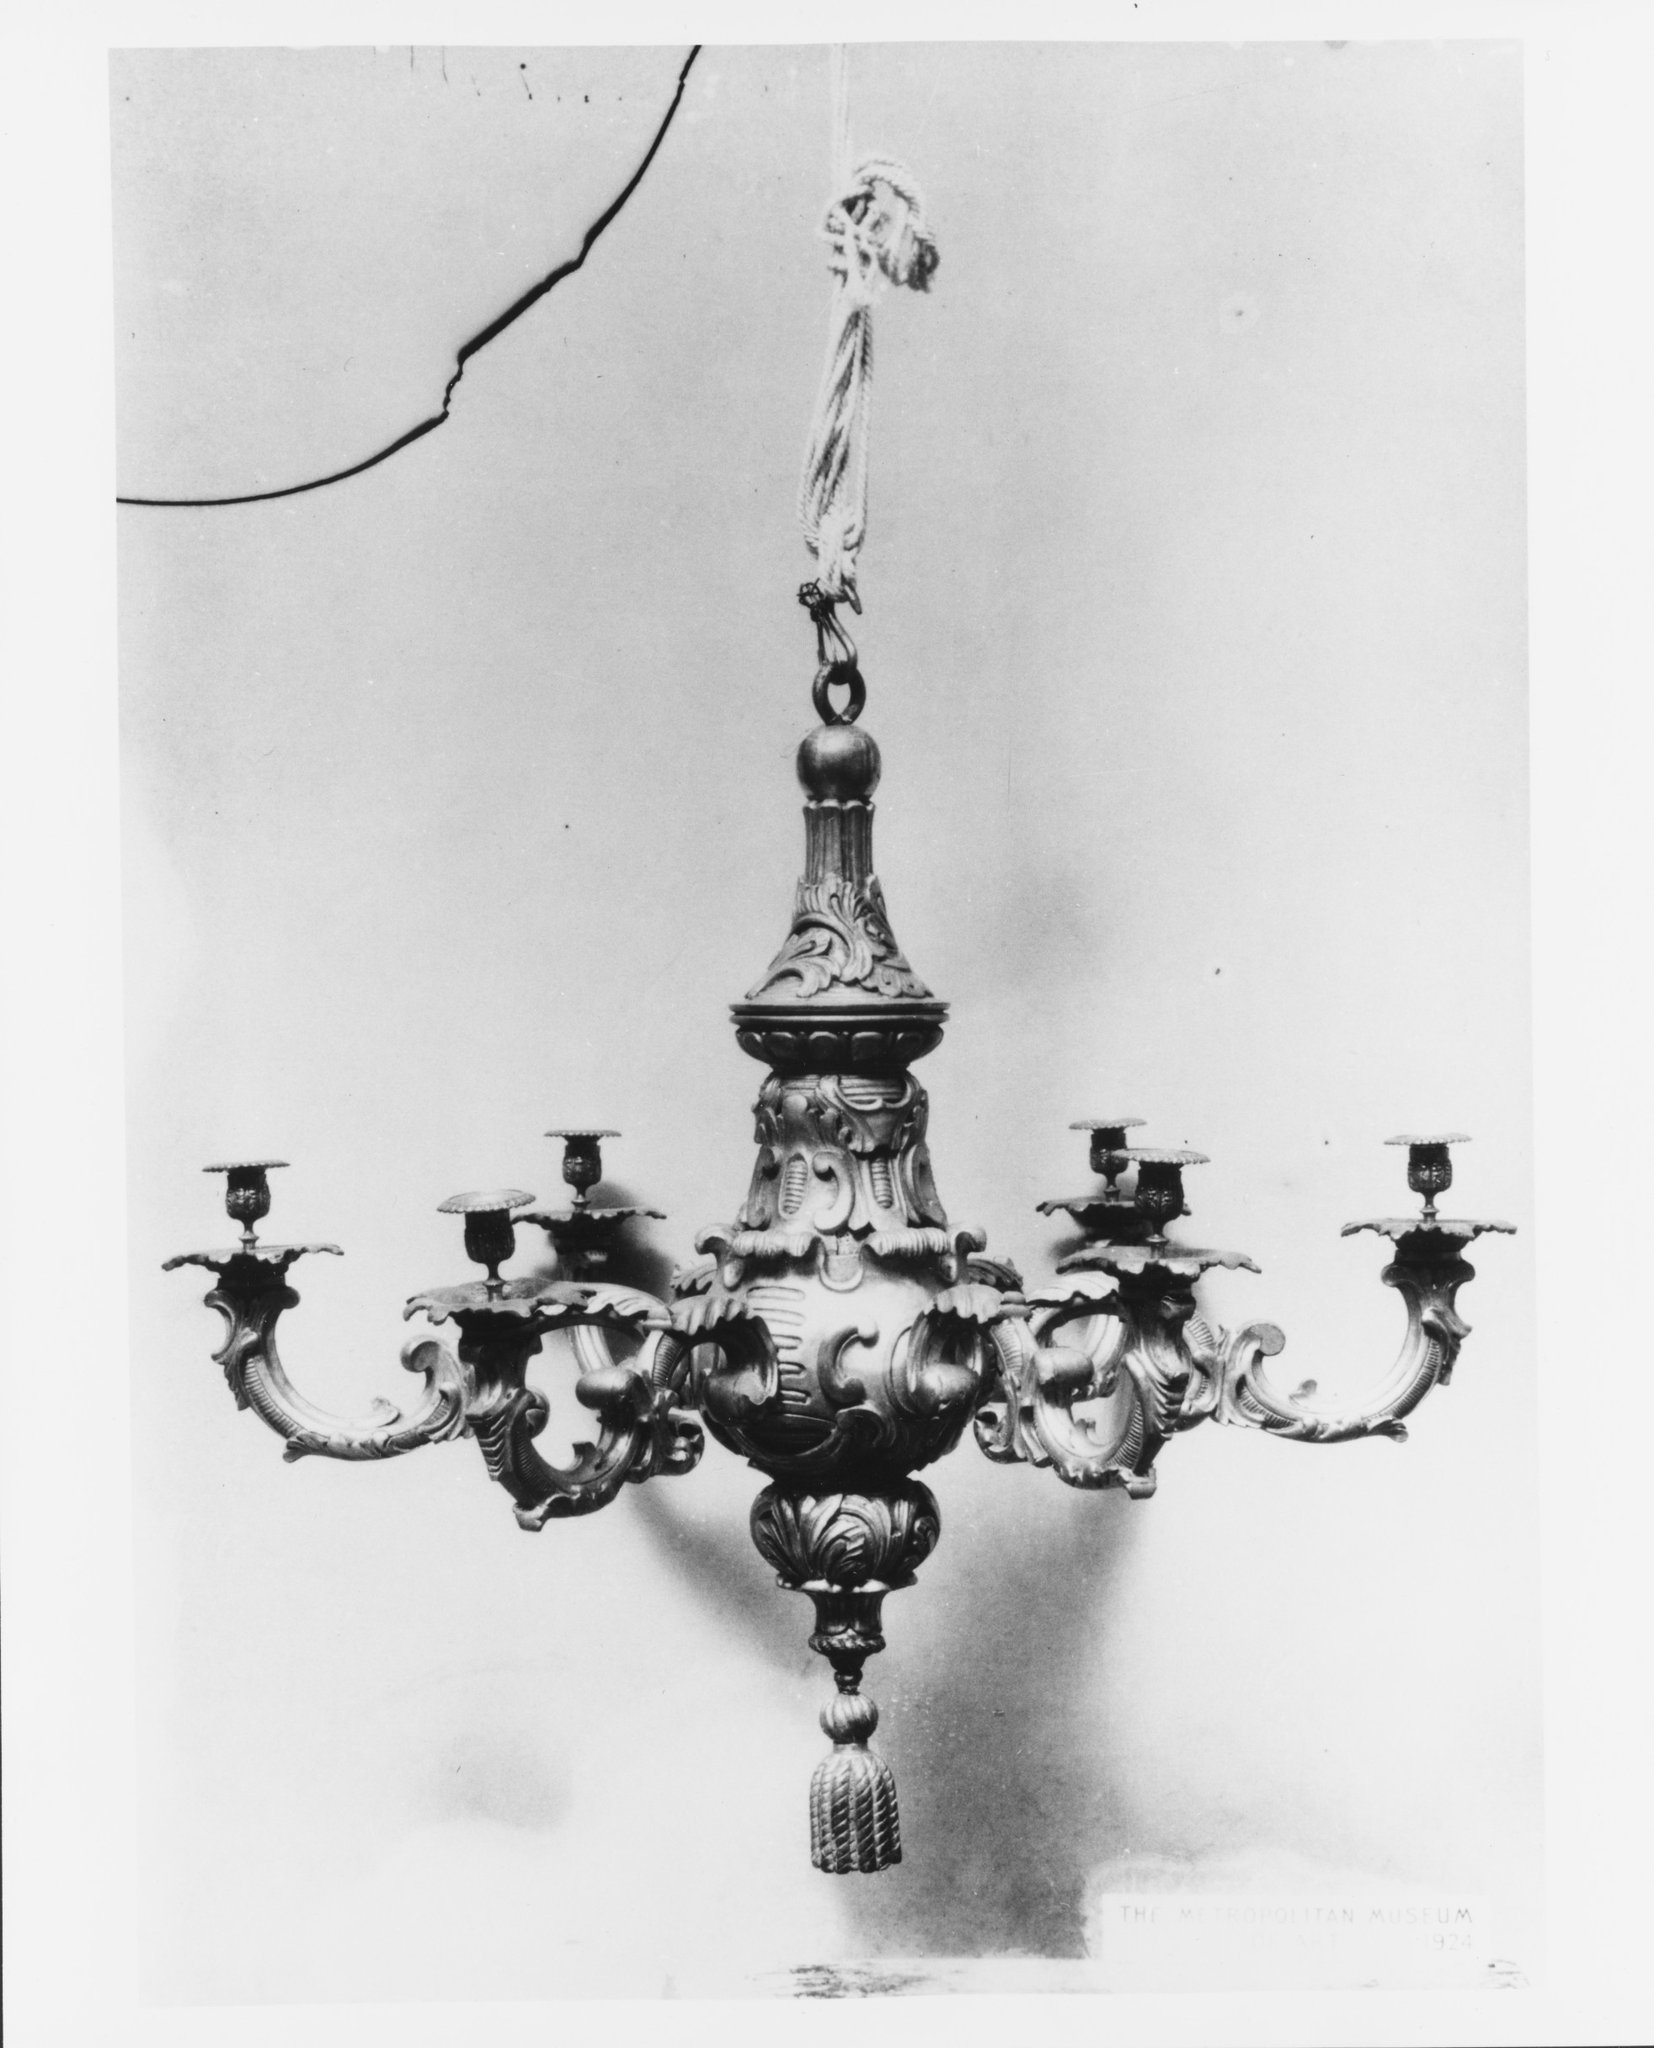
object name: chandelier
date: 1725-1750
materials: brass, wood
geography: england